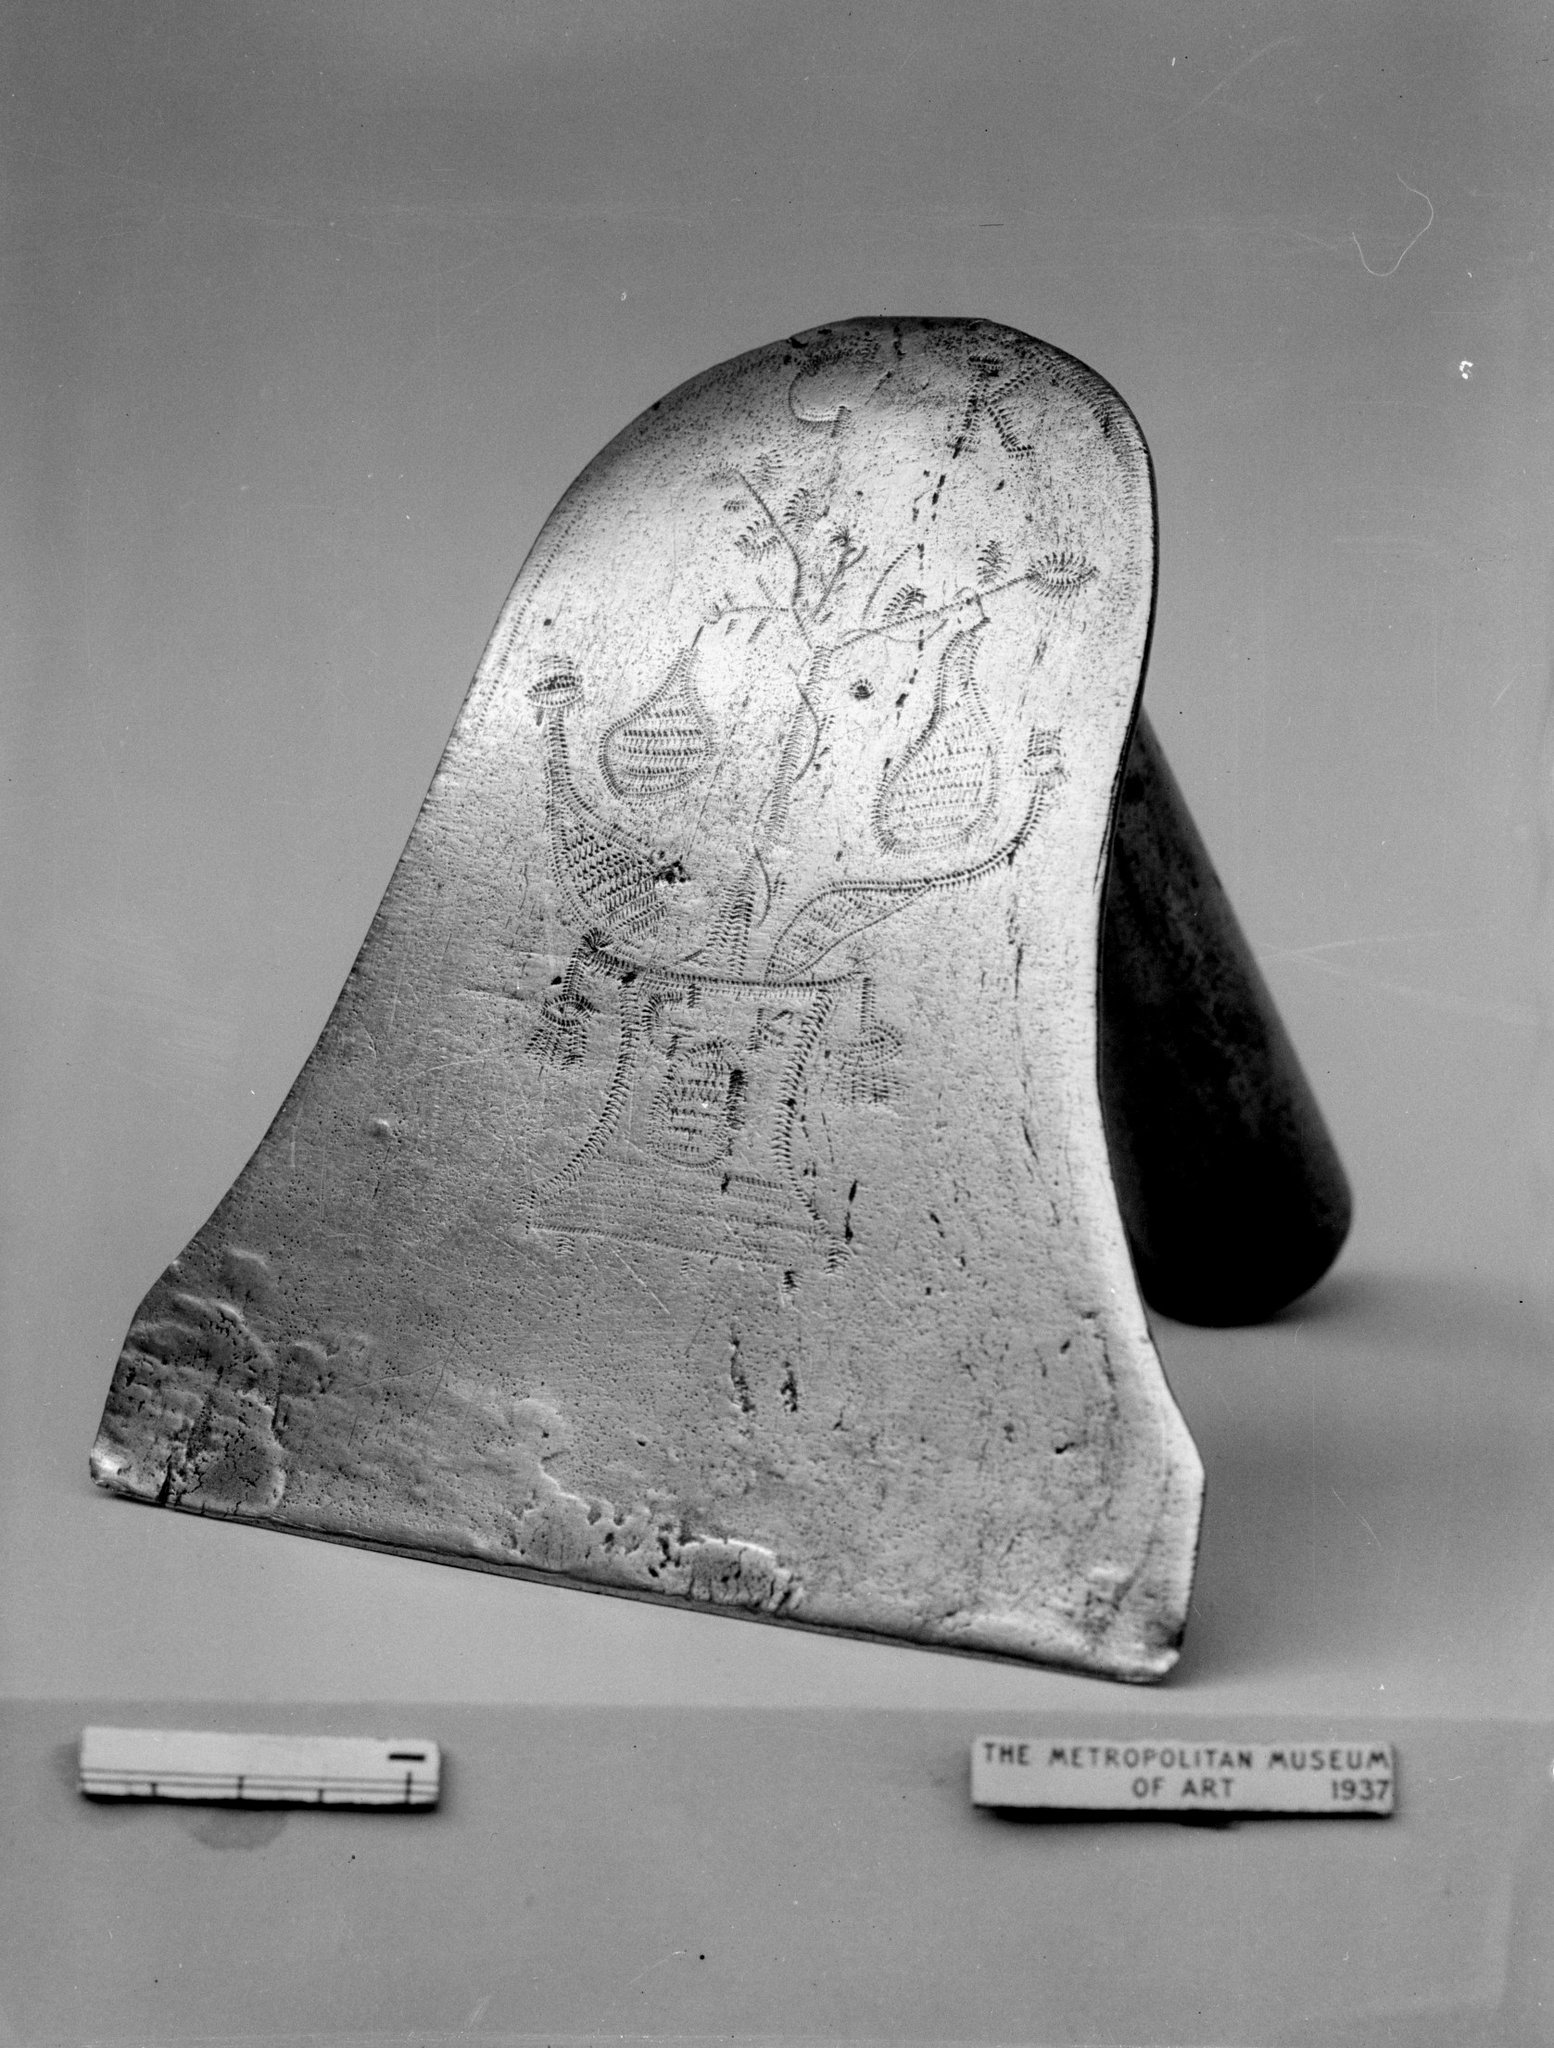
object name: dough board scraper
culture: american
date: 1800-1830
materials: iron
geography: united states